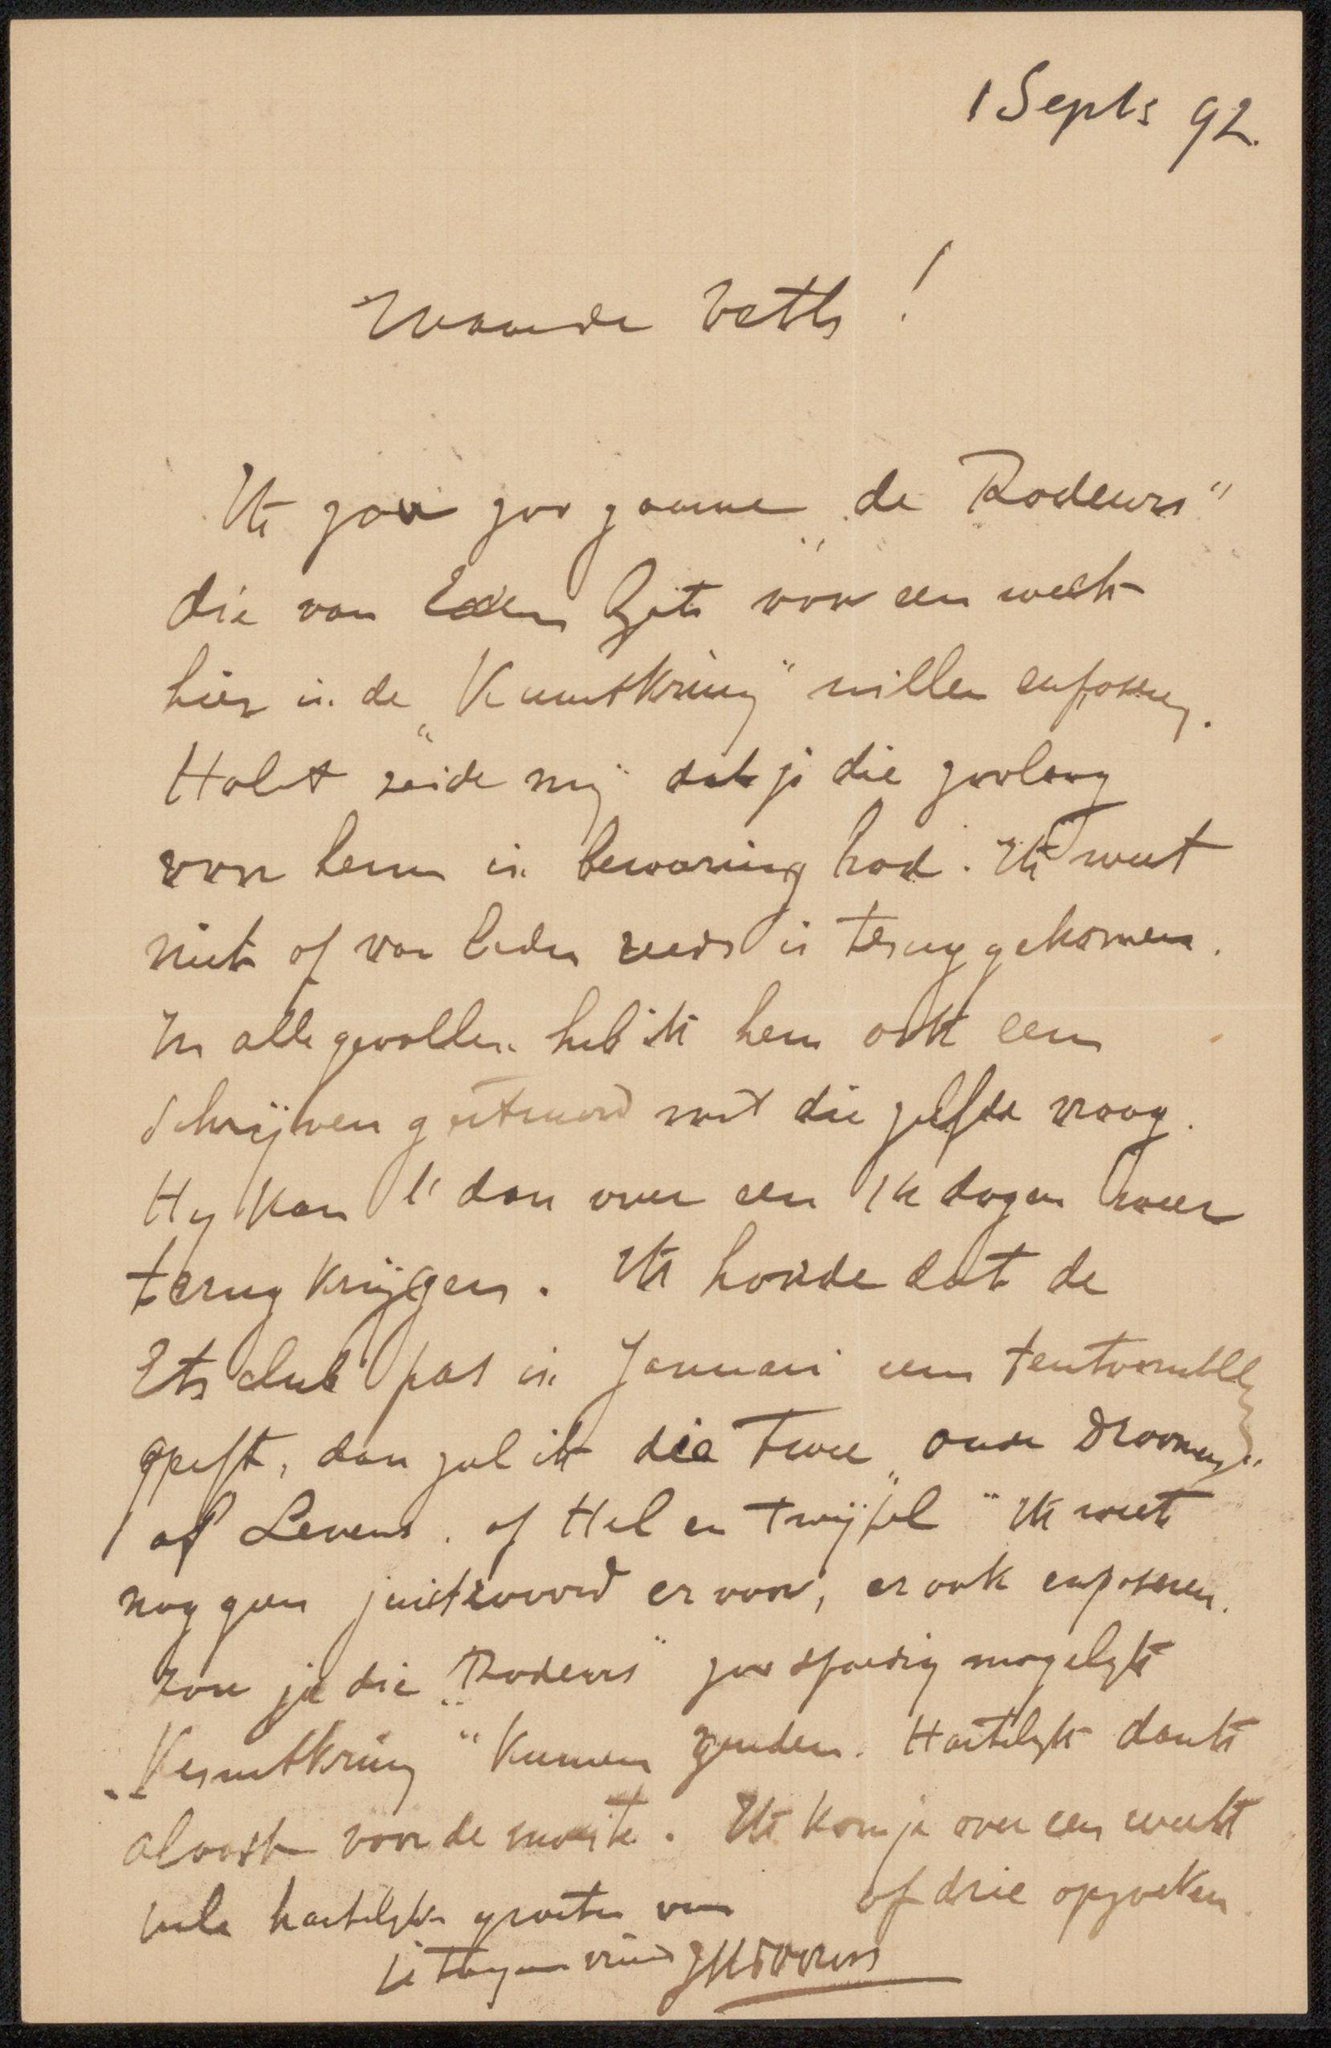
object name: letter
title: Brief aan Jan Veth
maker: jan toorop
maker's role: draughtsman, painter, print maker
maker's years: 1858-1928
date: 1874-1925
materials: ink, paper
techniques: pen, writing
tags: painter, print maker, draughtsman, jan veth, frederik van eeden, richard nicolaüs roland holst, drawing, exhibition ~ art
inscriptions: collector's mark: ‘RPK’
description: Brief gedateerd 1 Sept 92 in latere hand.